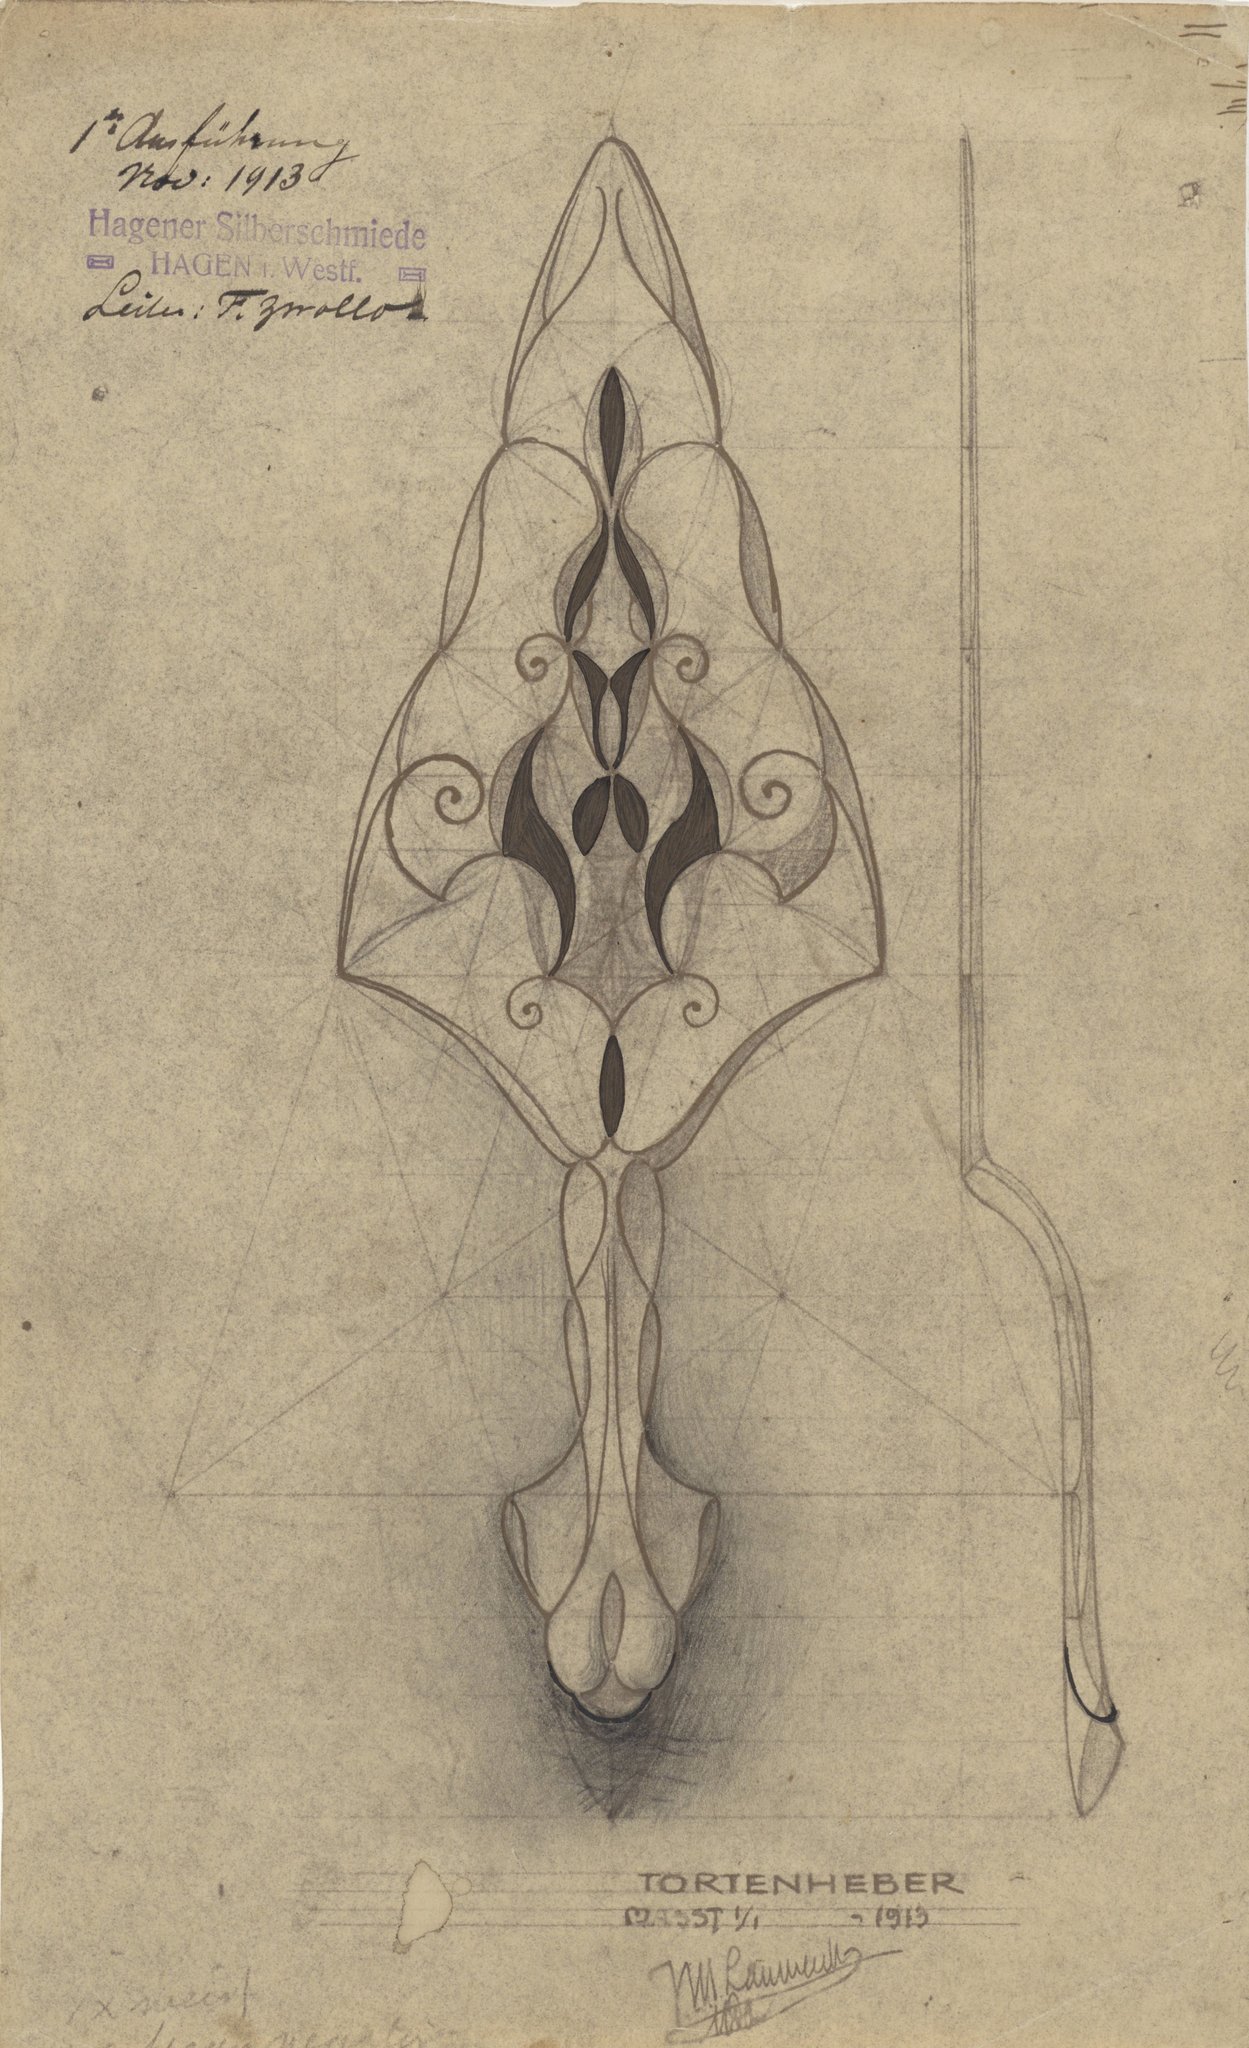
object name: design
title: Ontwerp voor een taartschep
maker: mathieu lauweriks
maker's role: designer, draughtsman, print maker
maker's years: 1864-1932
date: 1913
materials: ink, paper, pencil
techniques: blueprint, pen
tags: table-ware, cake, tart, pastry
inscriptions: date: ‘1913’